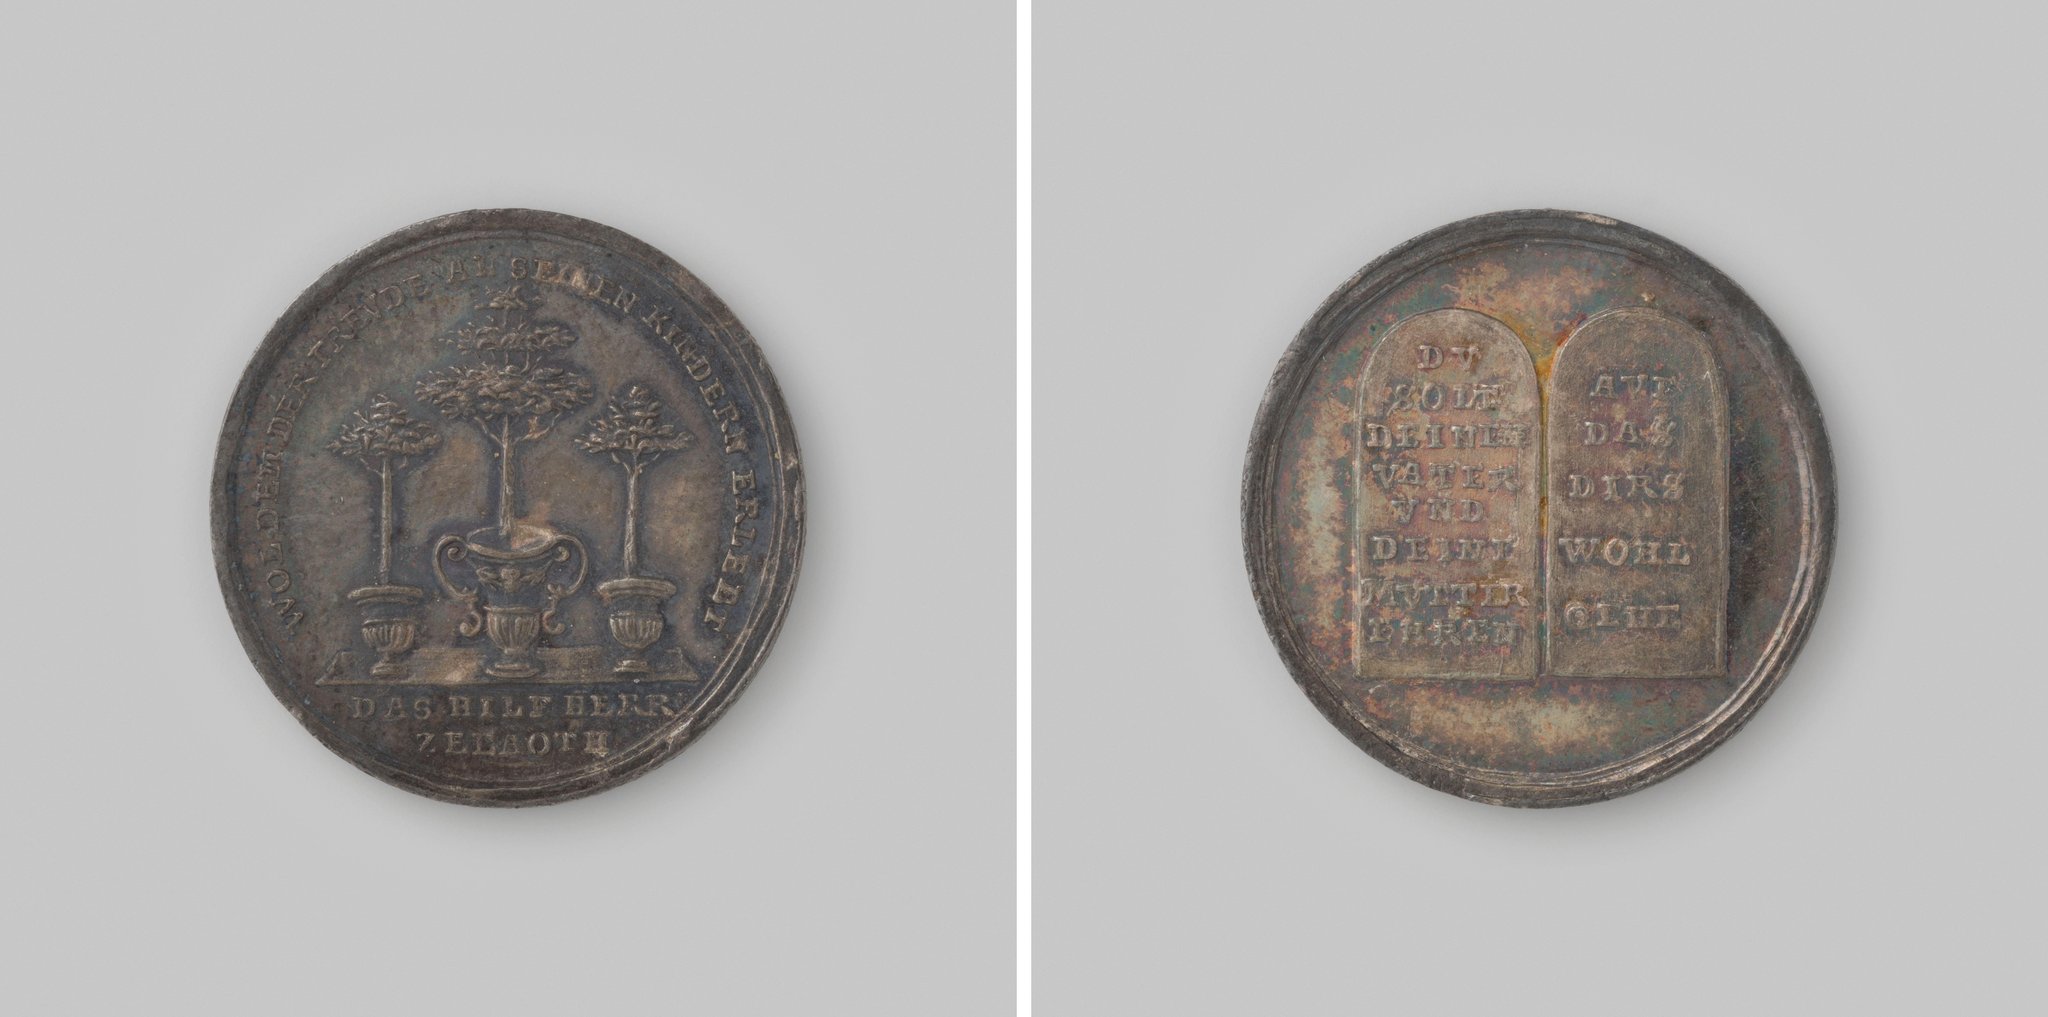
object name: coin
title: Duitse Keizerrijk, dukaat. Afslag in zilver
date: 1600-1800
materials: silver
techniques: striking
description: Afslag in zilver van een gouden gelegenheidsmunt. Voorzijde: op een tafelblad een grotwe vaas, omringd door twee kleinere. In iedere vaas een boom, de middelste met drie kruinen. Keerzijde: twee tafelen der wet, waarop spreuk in acht regels. Gladde rand.